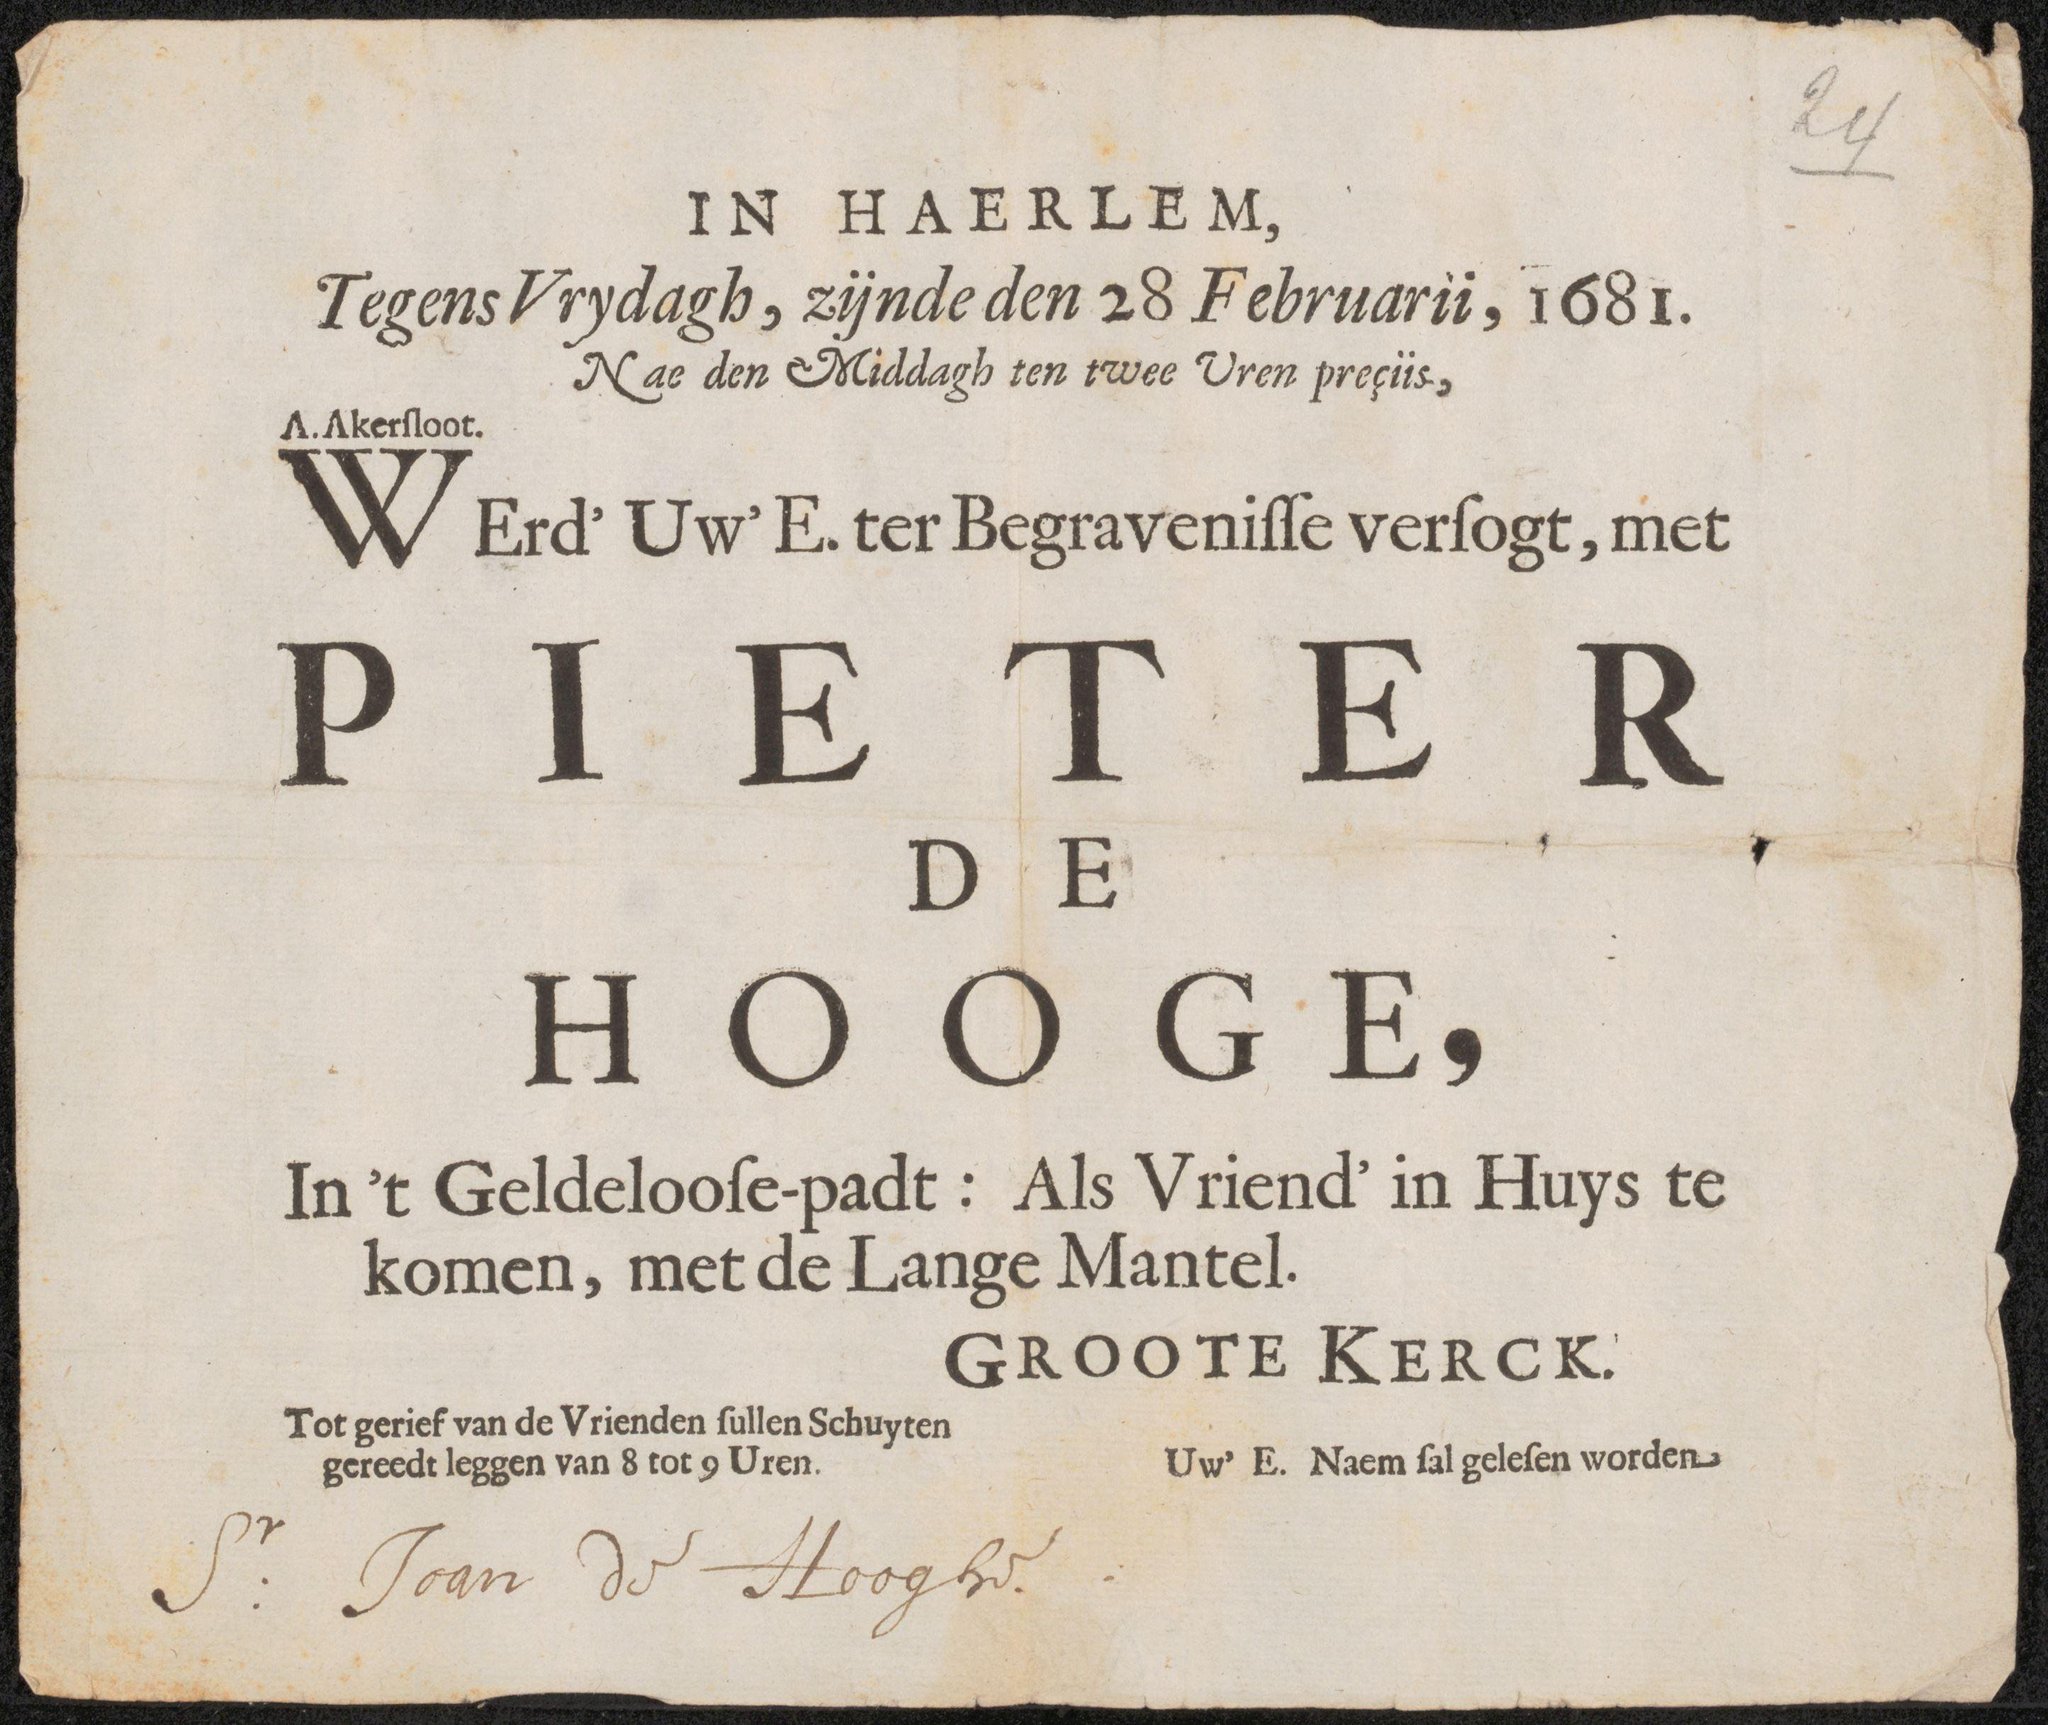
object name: invitation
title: Uitnodiging voor Johannes de Hooghe voor de de begrafenis van Pieter de Hooghe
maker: aris akersloot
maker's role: bookseller, printer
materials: ink, paper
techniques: letterpress printing, pen, writing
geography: haarlem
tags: amsterdam, johannes de hooghe (1608-1682)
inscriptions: collector's mark: Lugt 2233, watermark